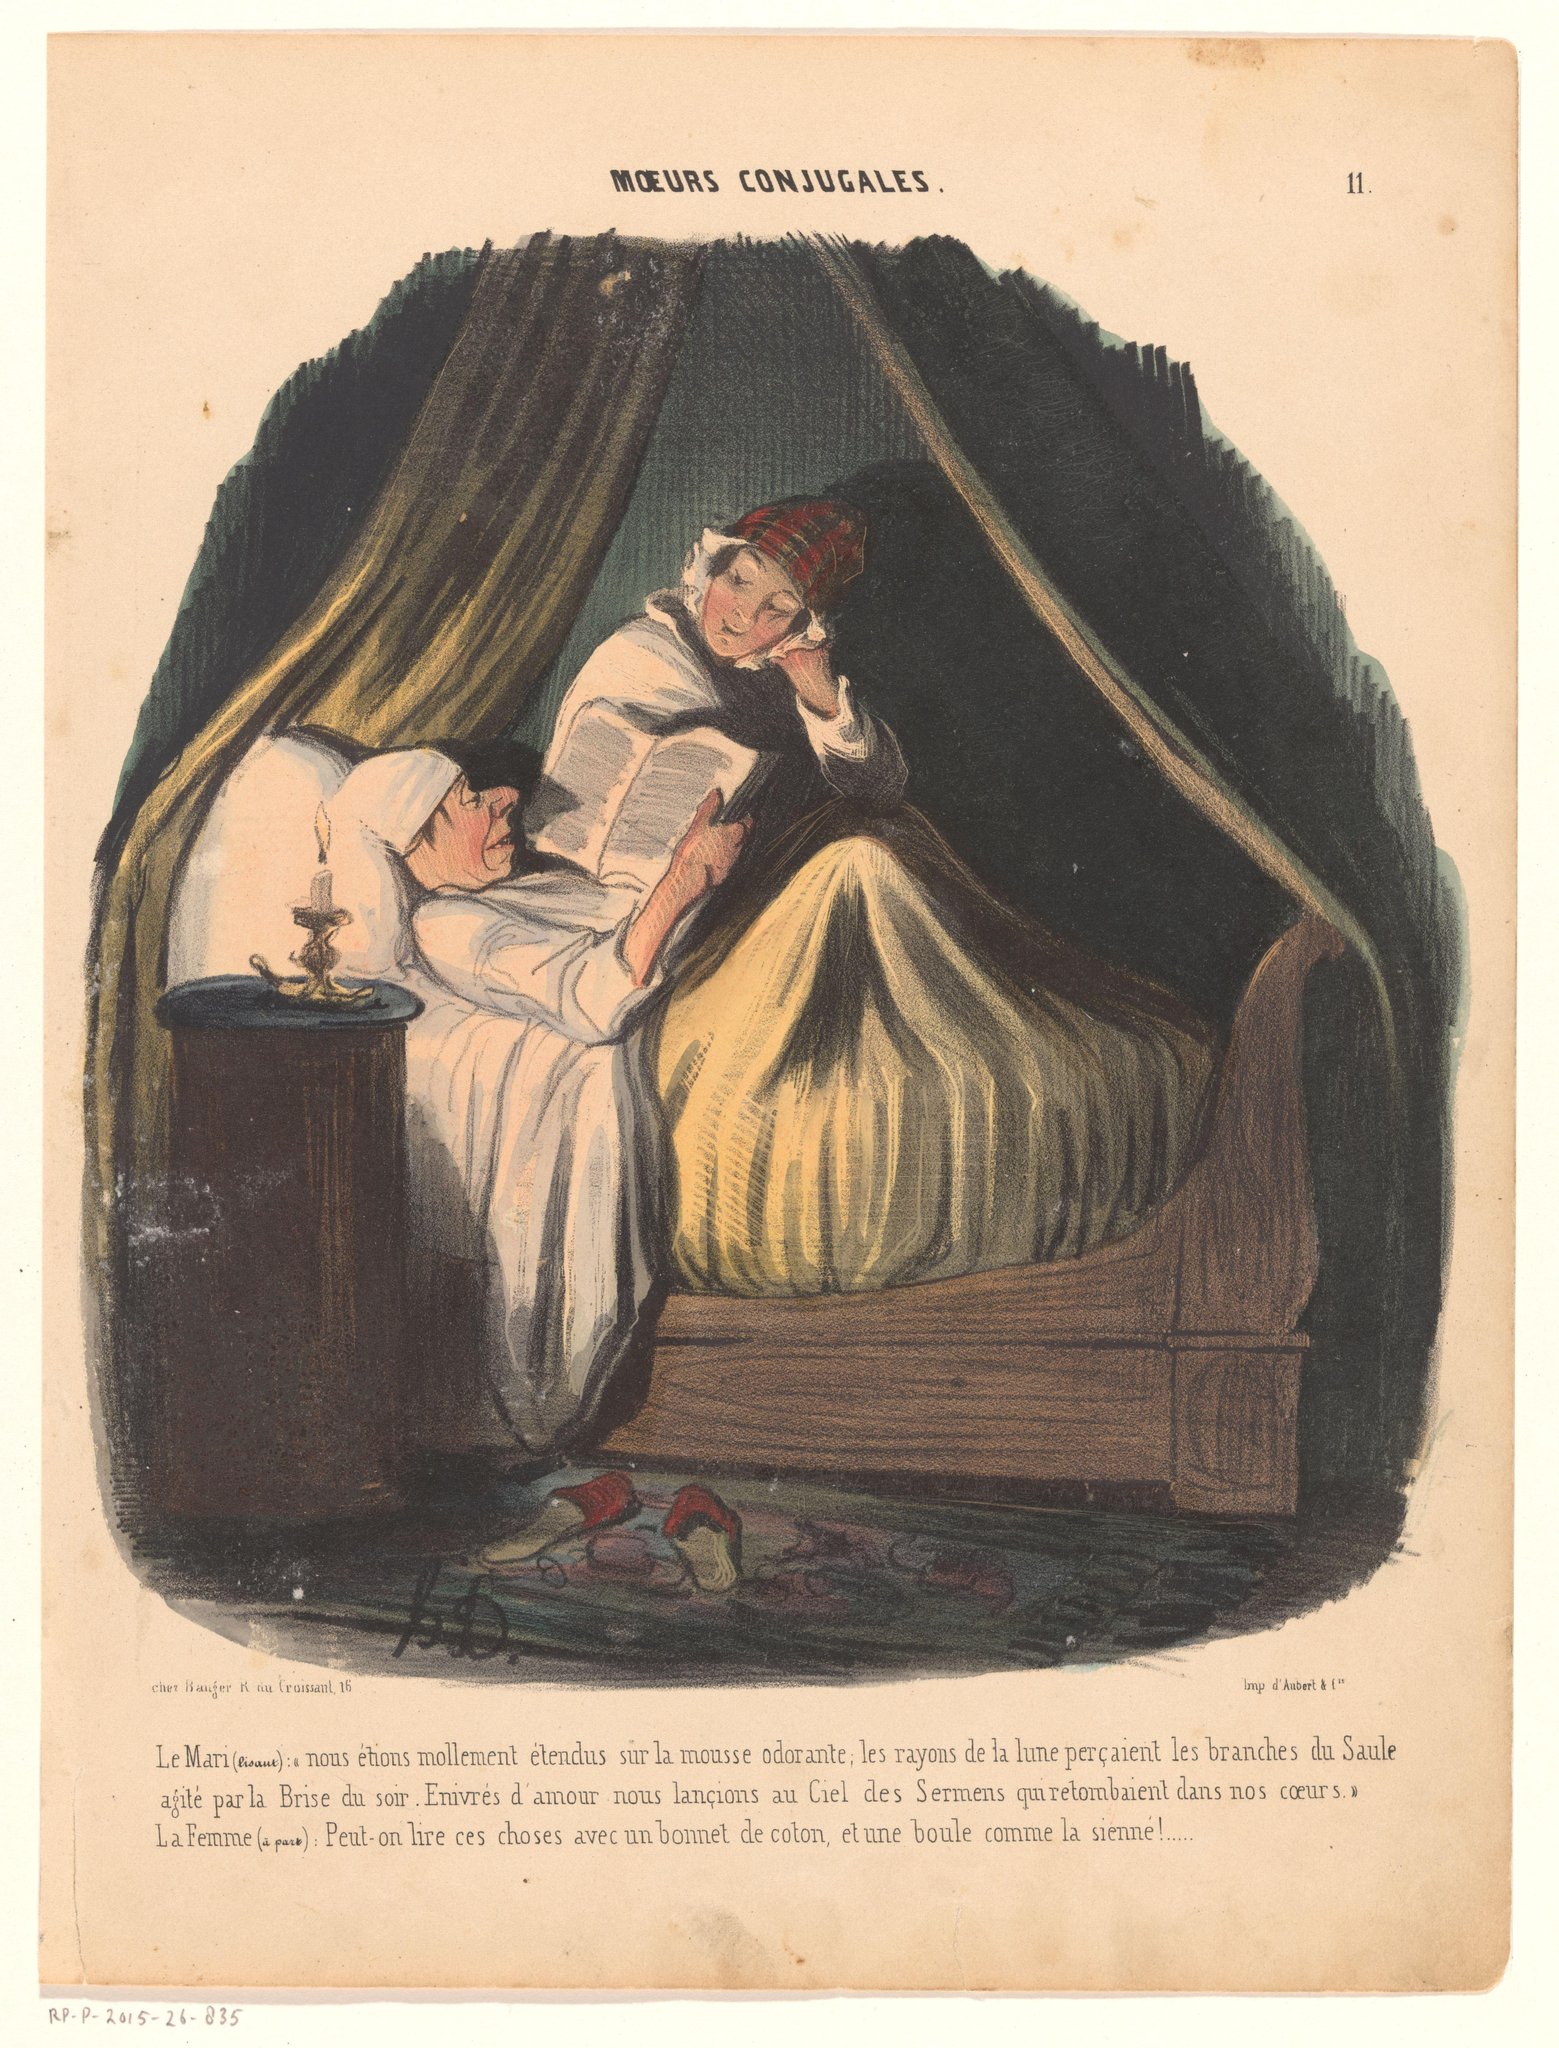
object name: print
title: Moeurs conjugales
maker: honoré daumier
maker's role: draughtsman, painter, print maker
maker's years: 1808-1879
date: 1839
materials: paper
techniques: hand coloring, lithograph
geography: paris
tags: candle, bed, newspaper, news-sheet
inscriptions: collector's mark: Lugt 4779, collector's mark: Lugt 2228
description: Op een nachtkastje naast het bed staat een brandende kaars, op de grond een paar pantoffels.